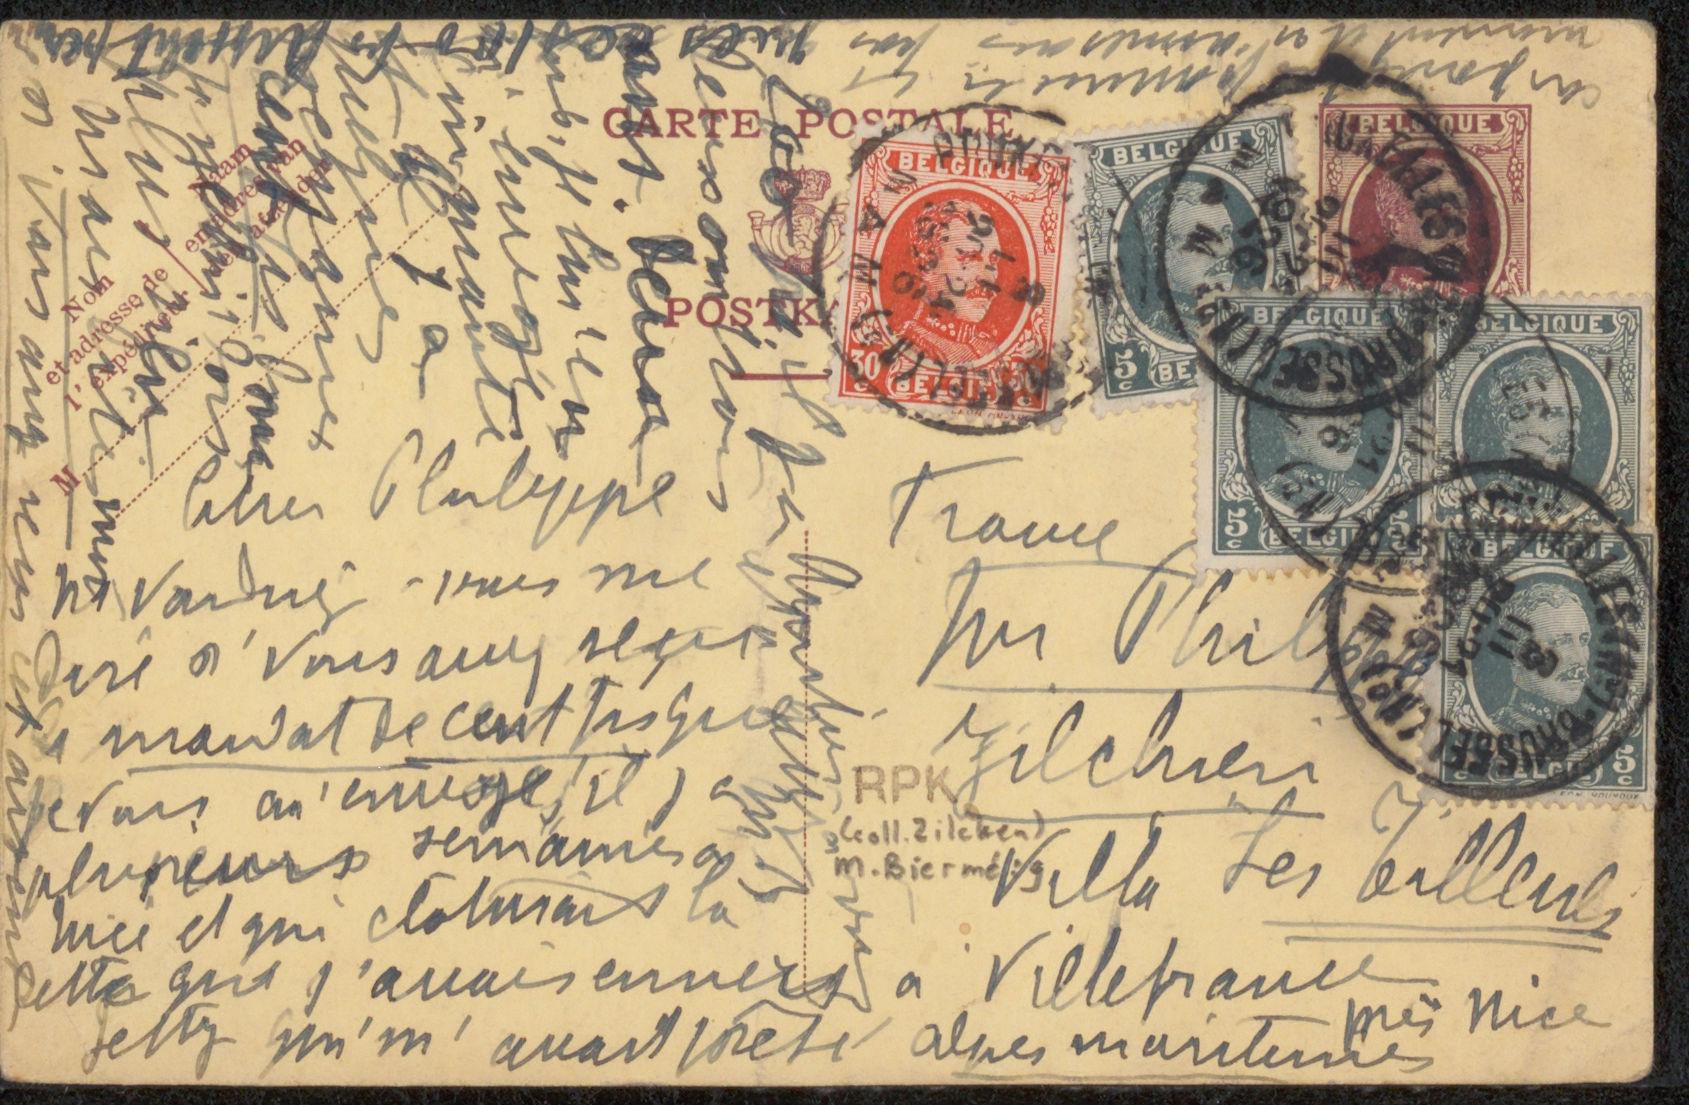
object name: postcard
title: Briefkaart aan Philip Zilcken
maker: maria biermé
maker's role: dichter, schrijver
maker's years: 1863-1932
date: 1916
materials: cardboard, ink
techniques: pen, writing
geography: brussels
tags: the hague, painter, draughtsman, philip zilcken, venice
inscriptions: collector's mark: ‘RPK’